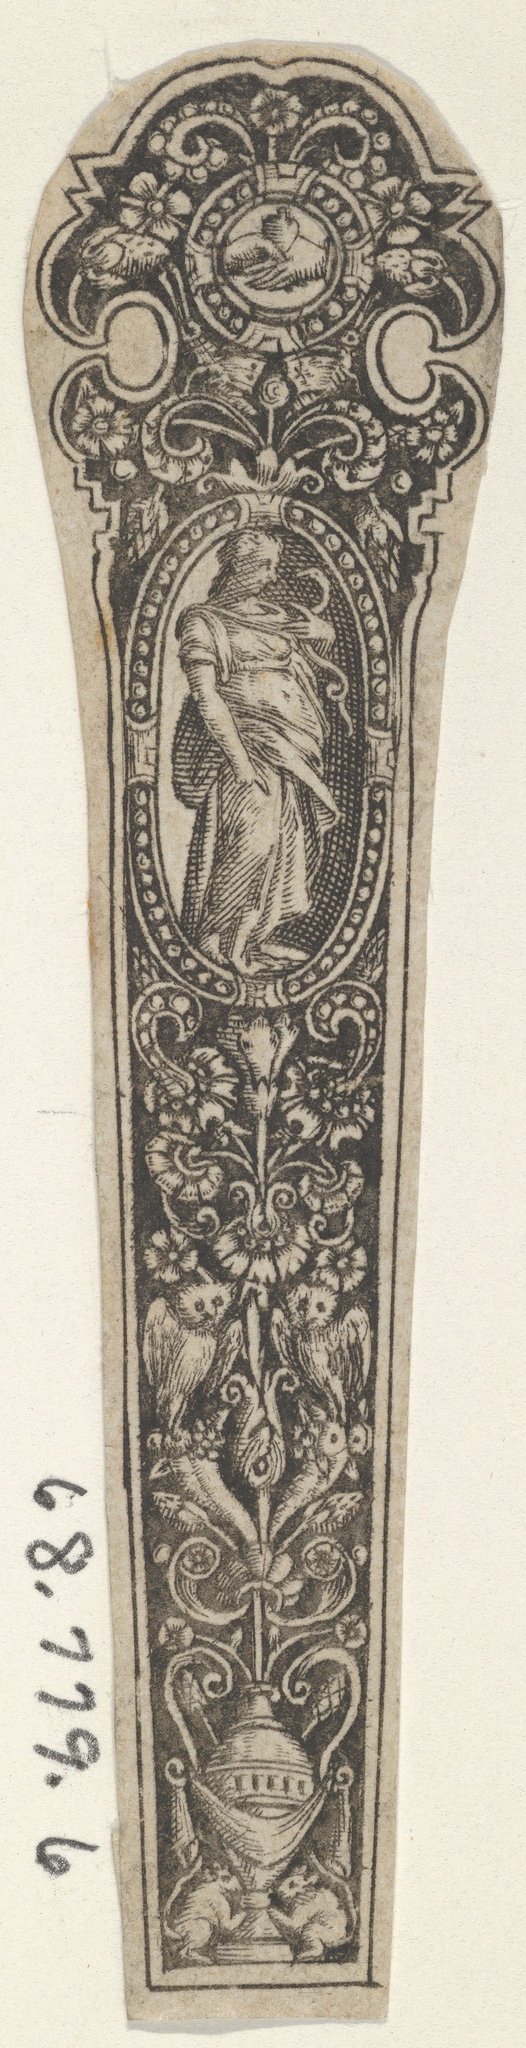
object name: print ornament architecture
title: Design for a Knife Handle with the Personification of Prudence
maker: johann theodor de bry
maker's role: artist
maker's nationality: netherlandish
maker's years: 1561-1623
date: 1580-1600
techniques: embroidery, engraving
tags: hilts,women,owls,snakes,squirrels